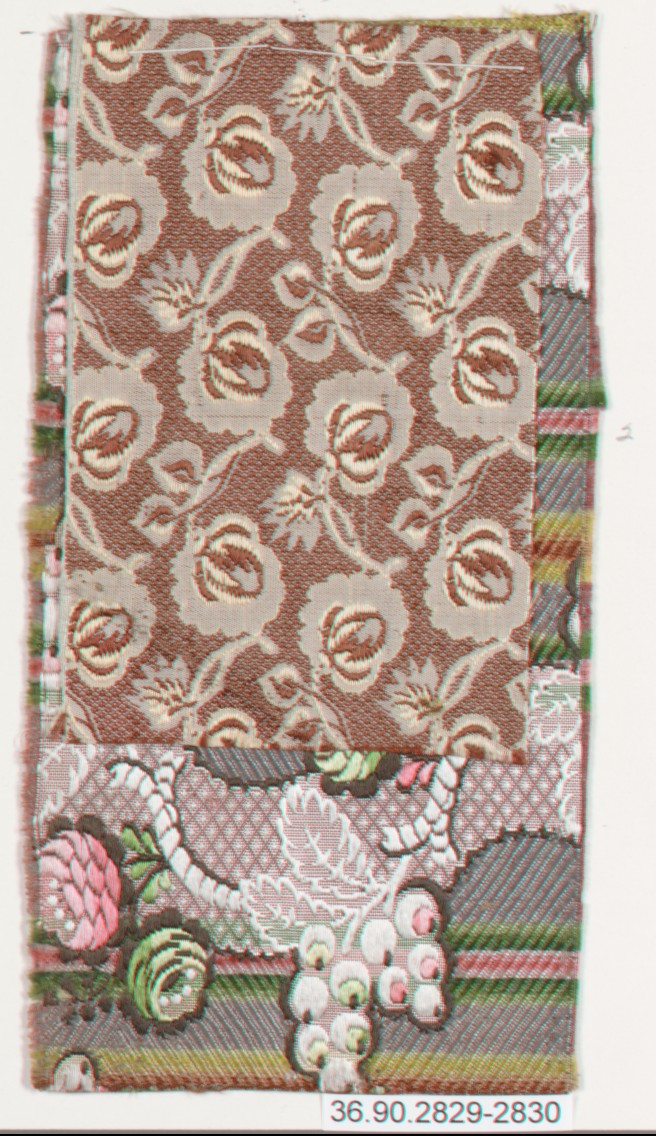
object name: piece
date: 1801-1900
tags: flowers,leaves